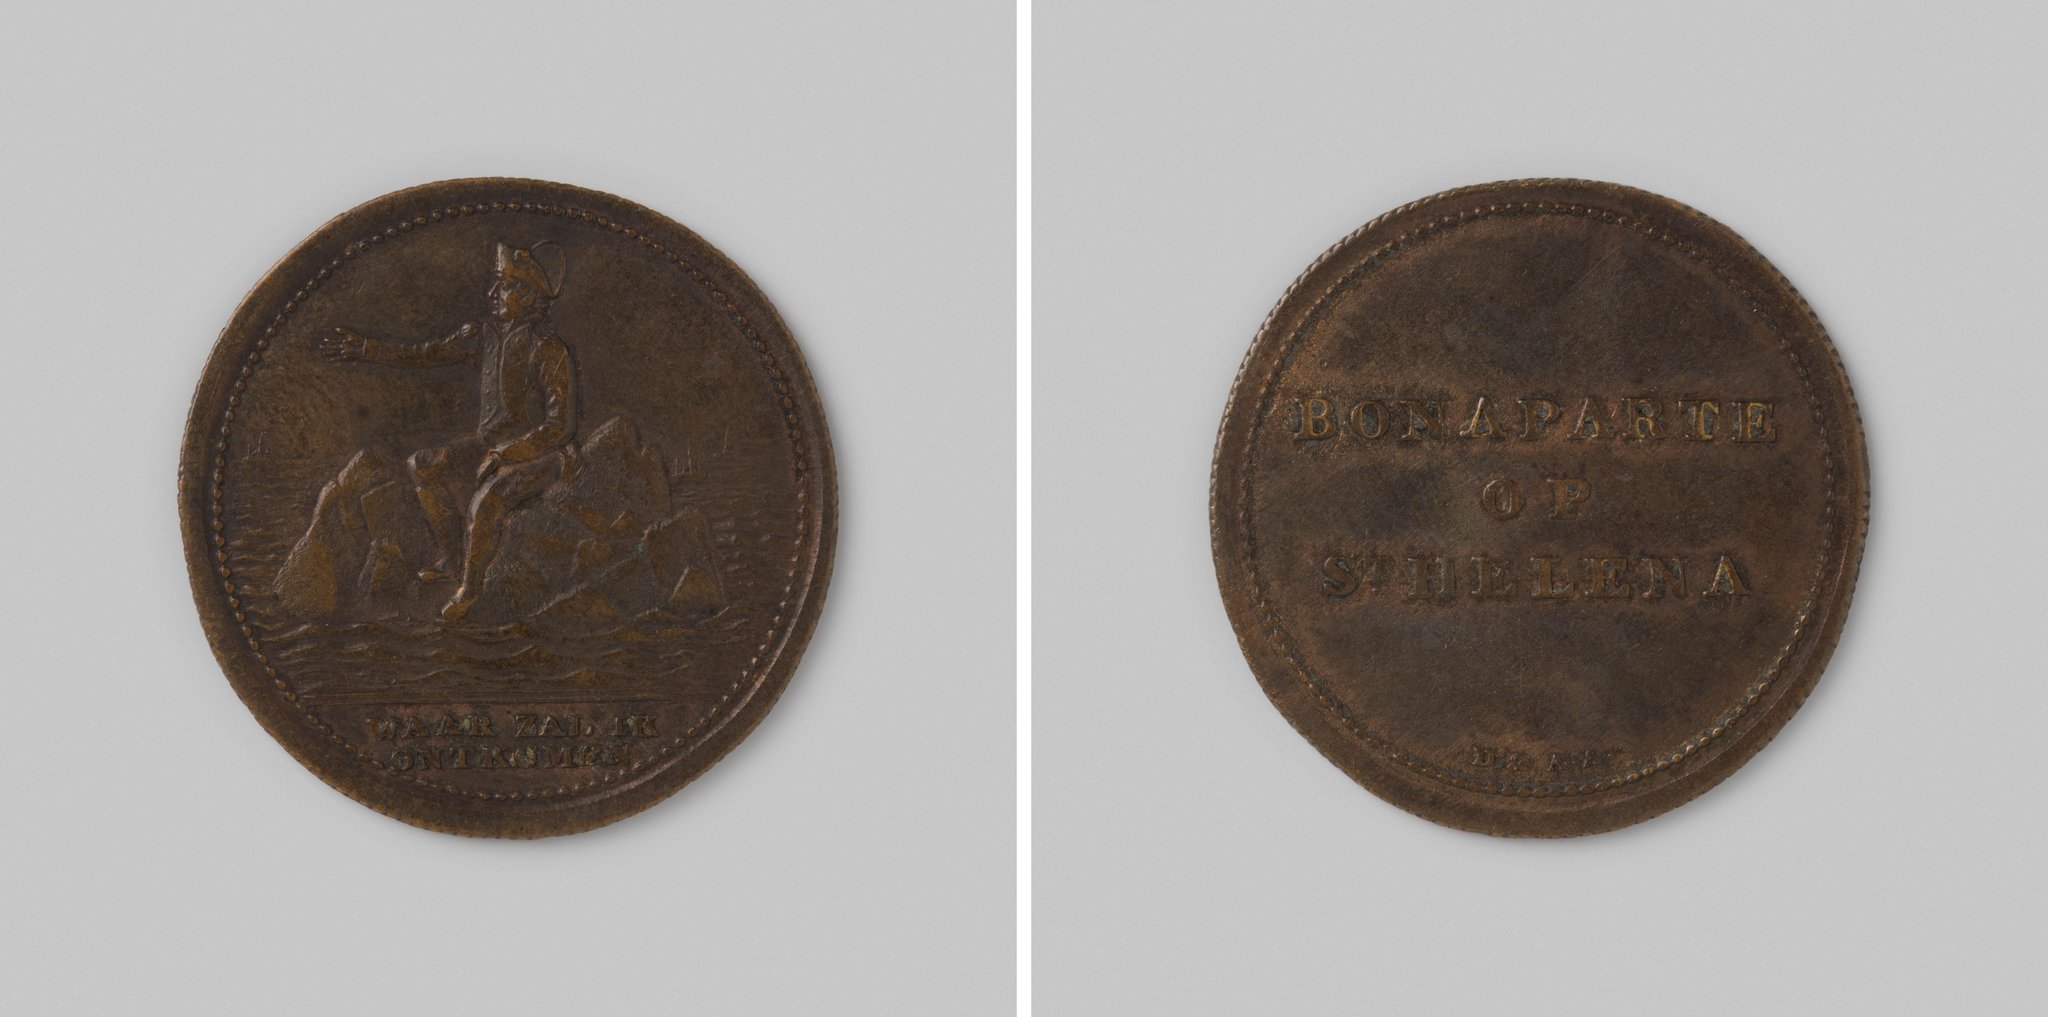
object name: history medal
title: Verbanning van Napoleon Bonaparte naar Sint Helena 1815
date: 1815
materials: copper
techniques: striking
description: Koperen penning, op de voorzijde Napoleon zittend op een steenklomp op zee, met afsnedetekst, op de keerzijde drie regels tekst.